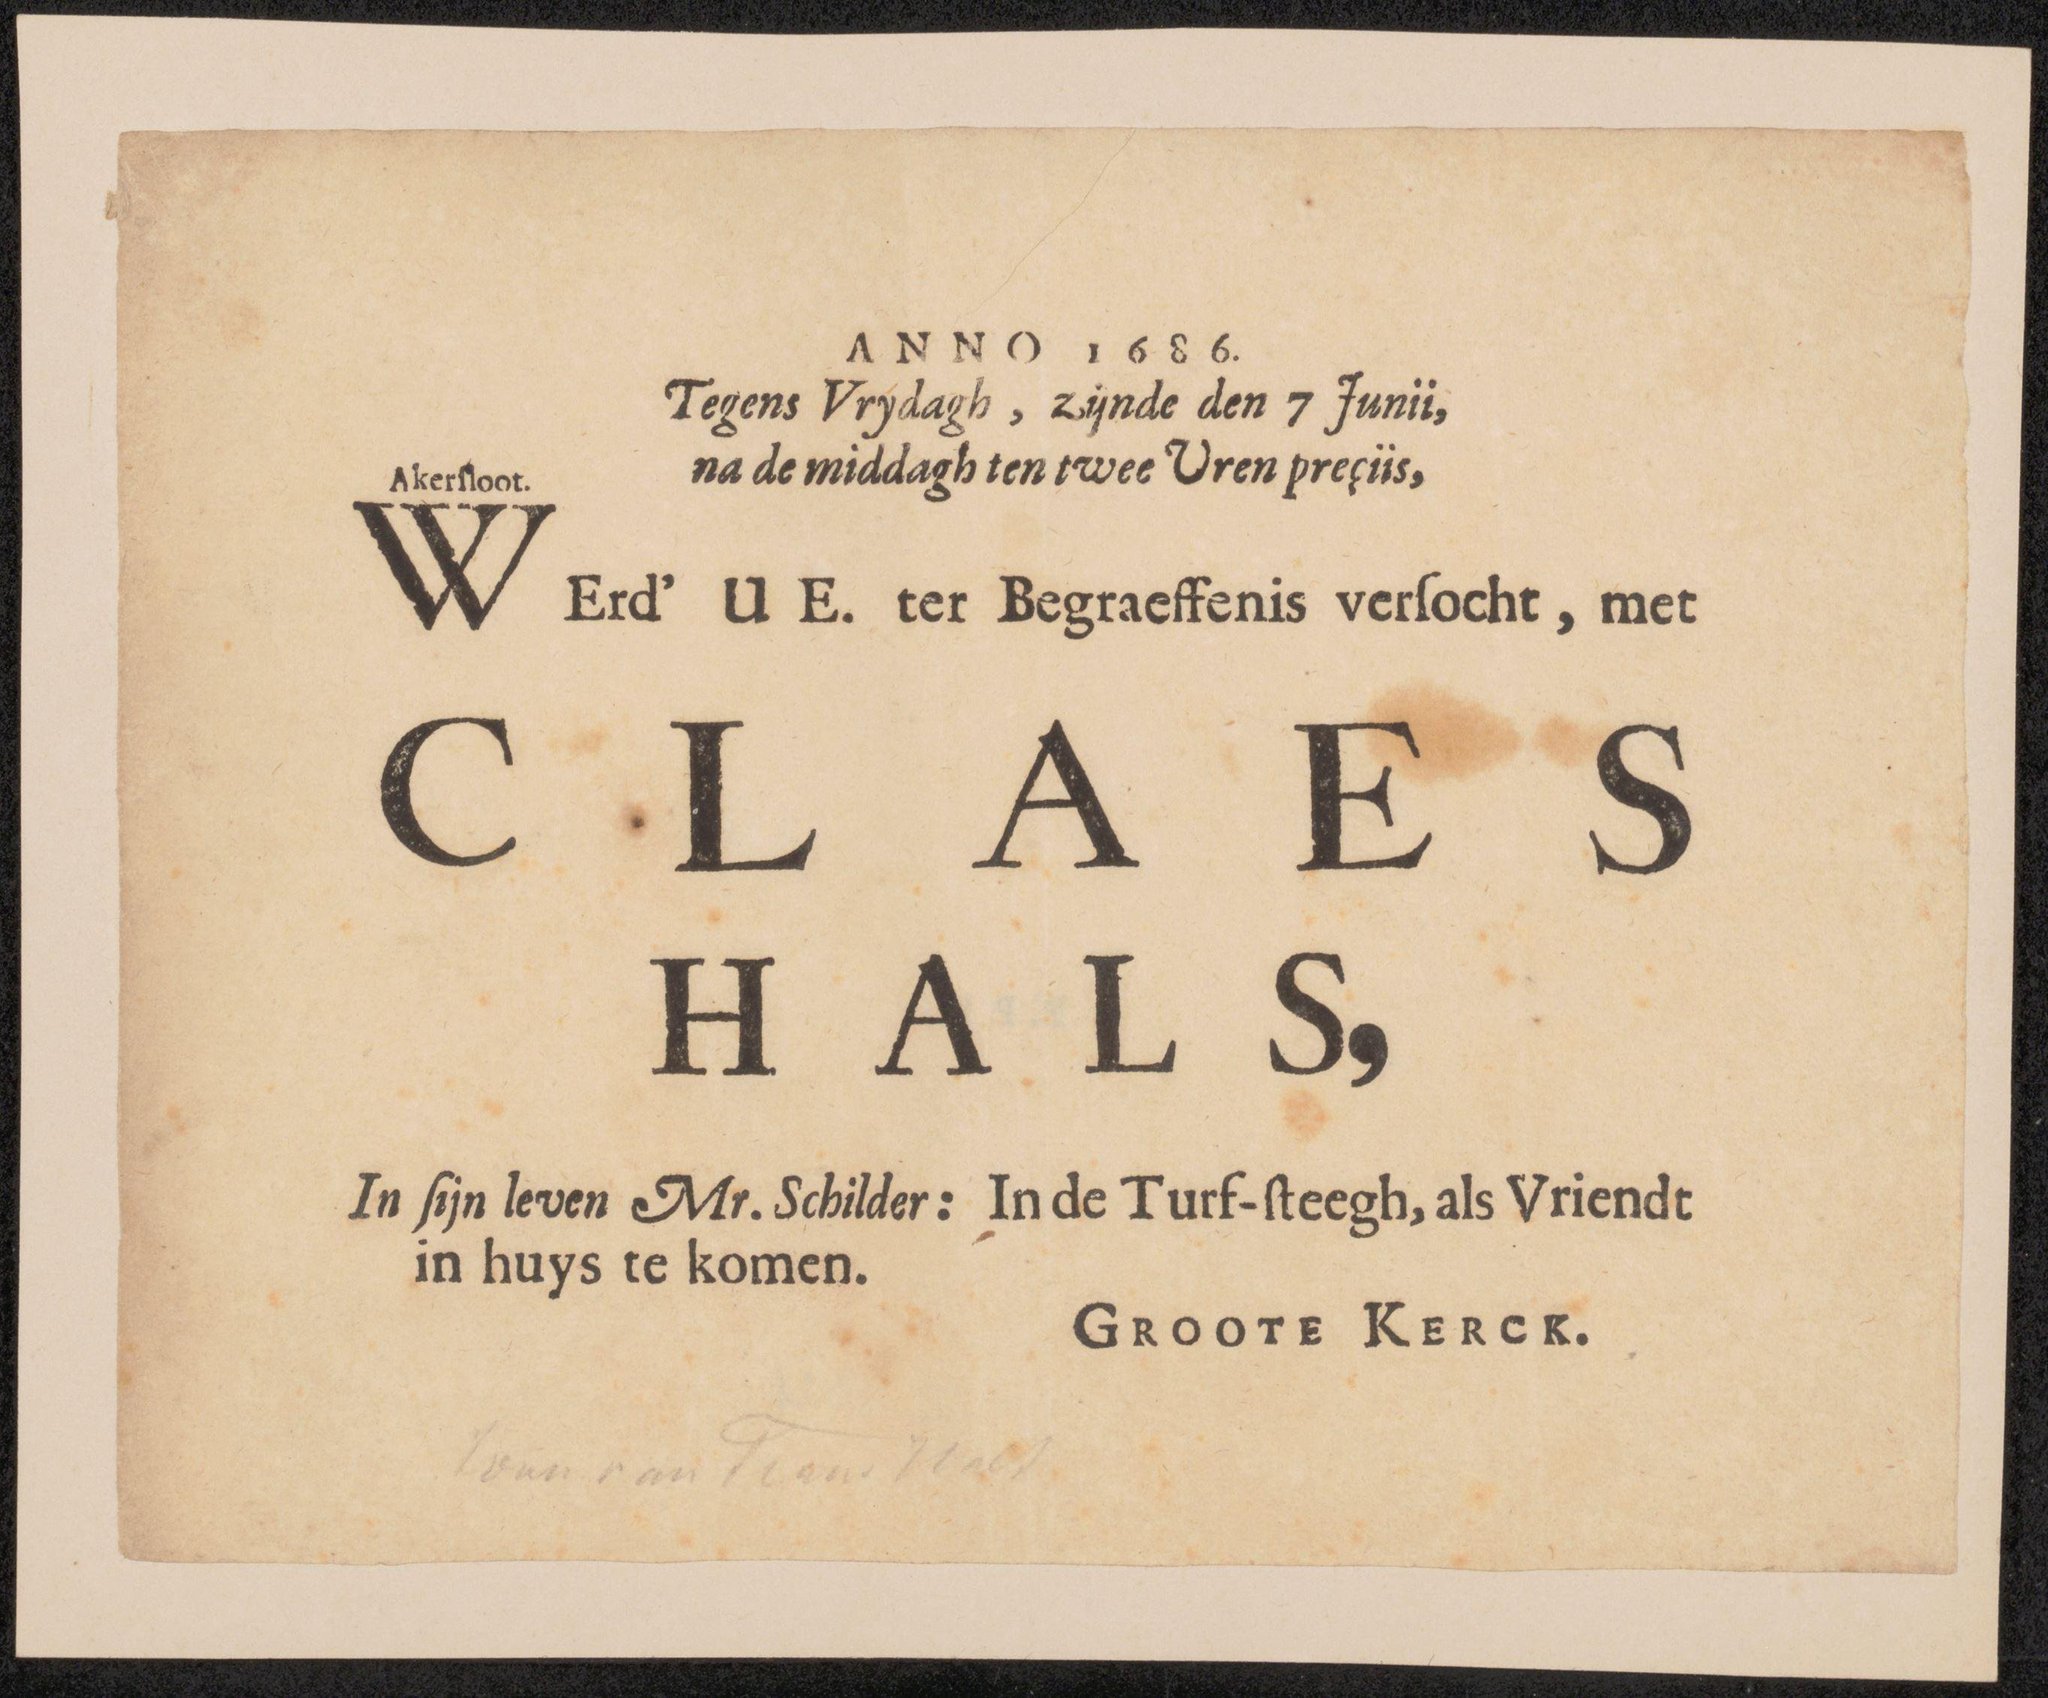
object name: invitation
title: Uitnodiging voor de begrafenis van Nicolaes Hals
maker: Anonymous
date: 1686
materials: paper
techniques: printing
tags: nicolaes hals, haarlem